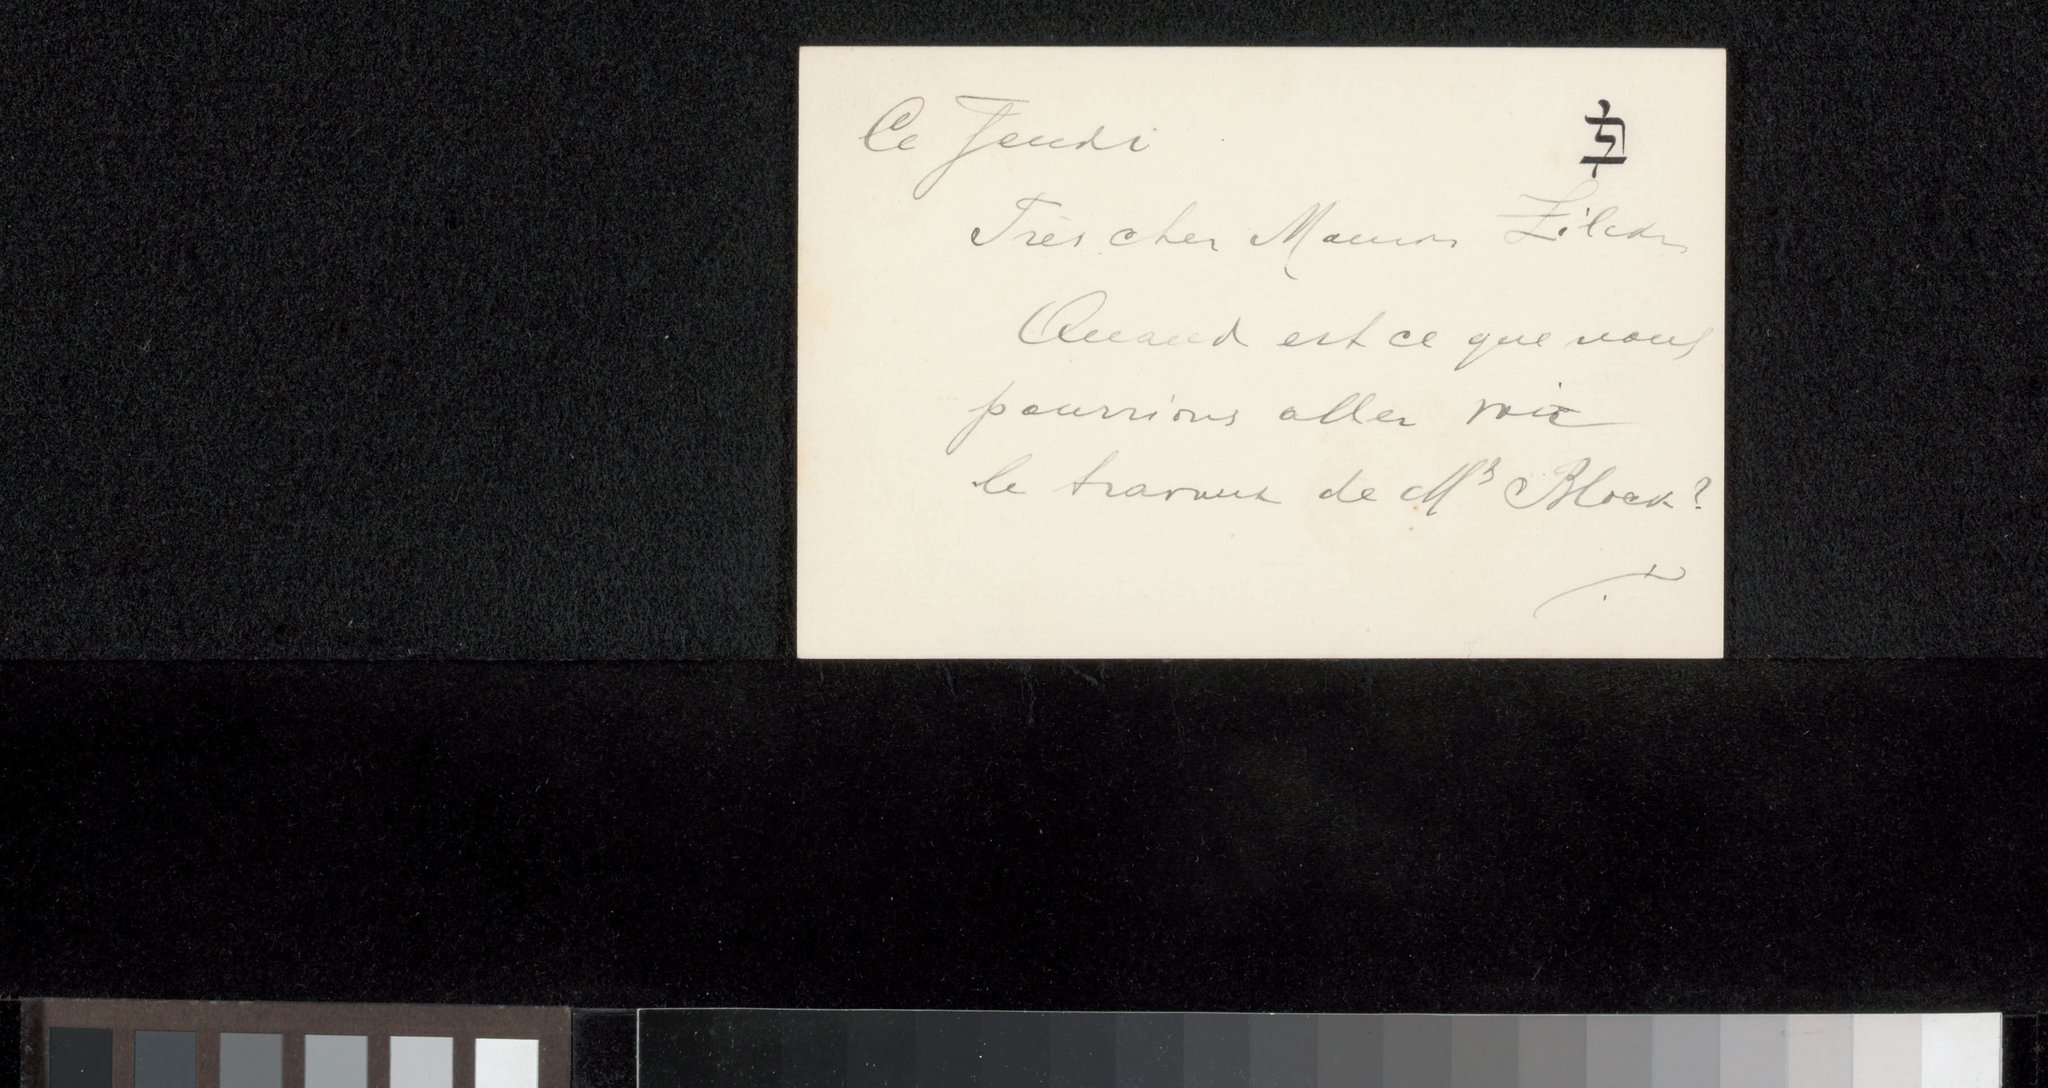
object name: letter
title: Brief aan Philip Zilcken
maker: léo berlinn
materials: cardboard, ink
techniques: pen, writing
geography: the hague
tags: the hague, painter, draughtsman, philip zilcken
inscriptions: monogram: ‘LB’, collector's mark: ‘RPK’